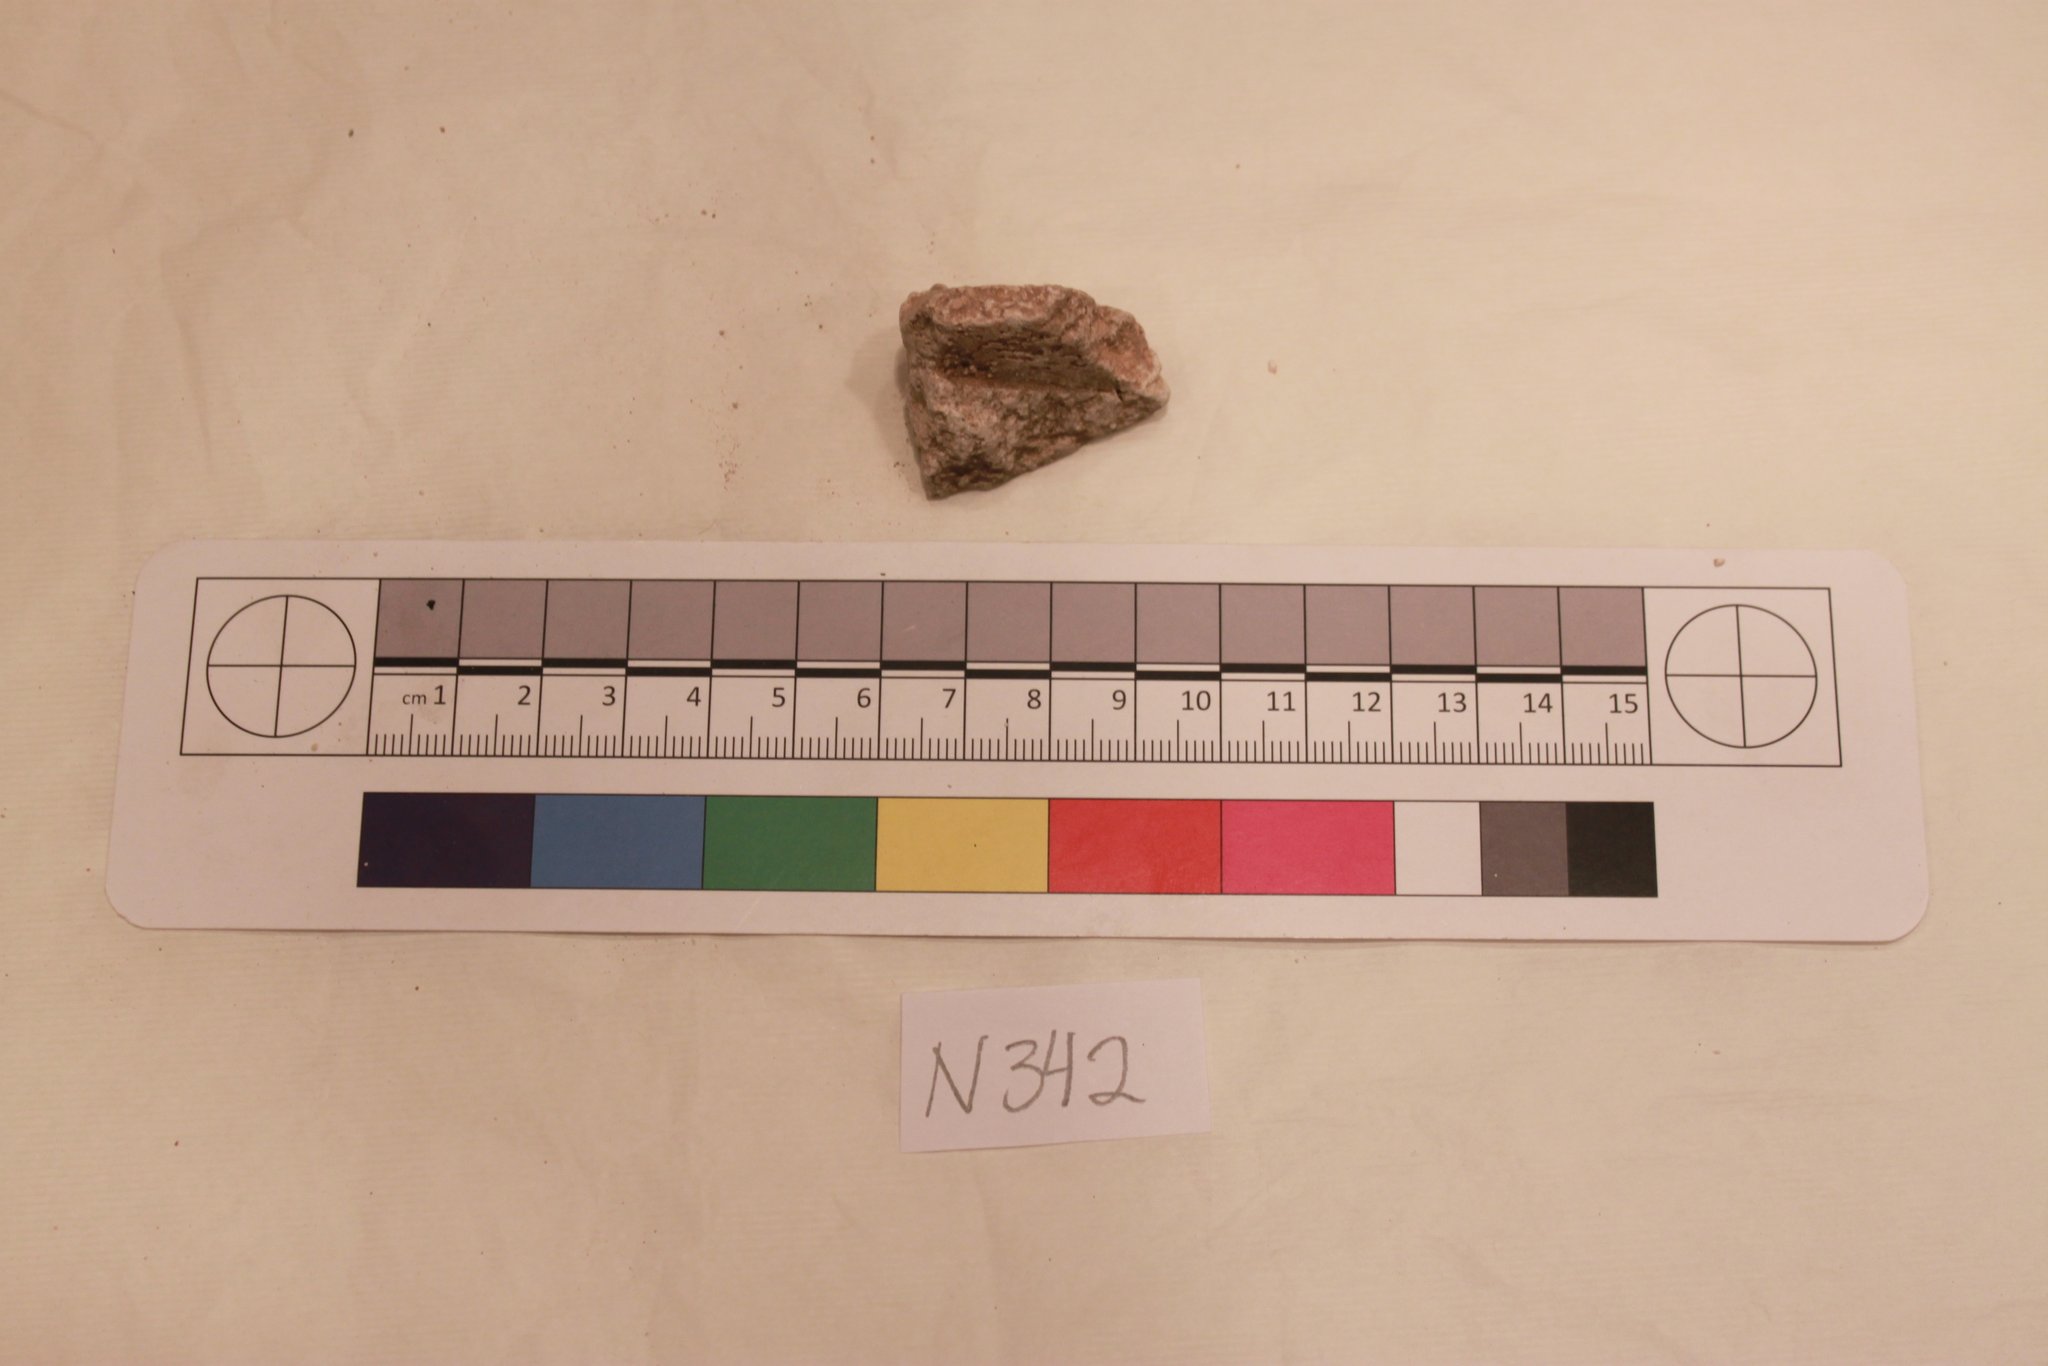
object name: fragment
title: Stucco Fragment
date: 701-1200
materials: plaster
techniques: carving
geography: iran